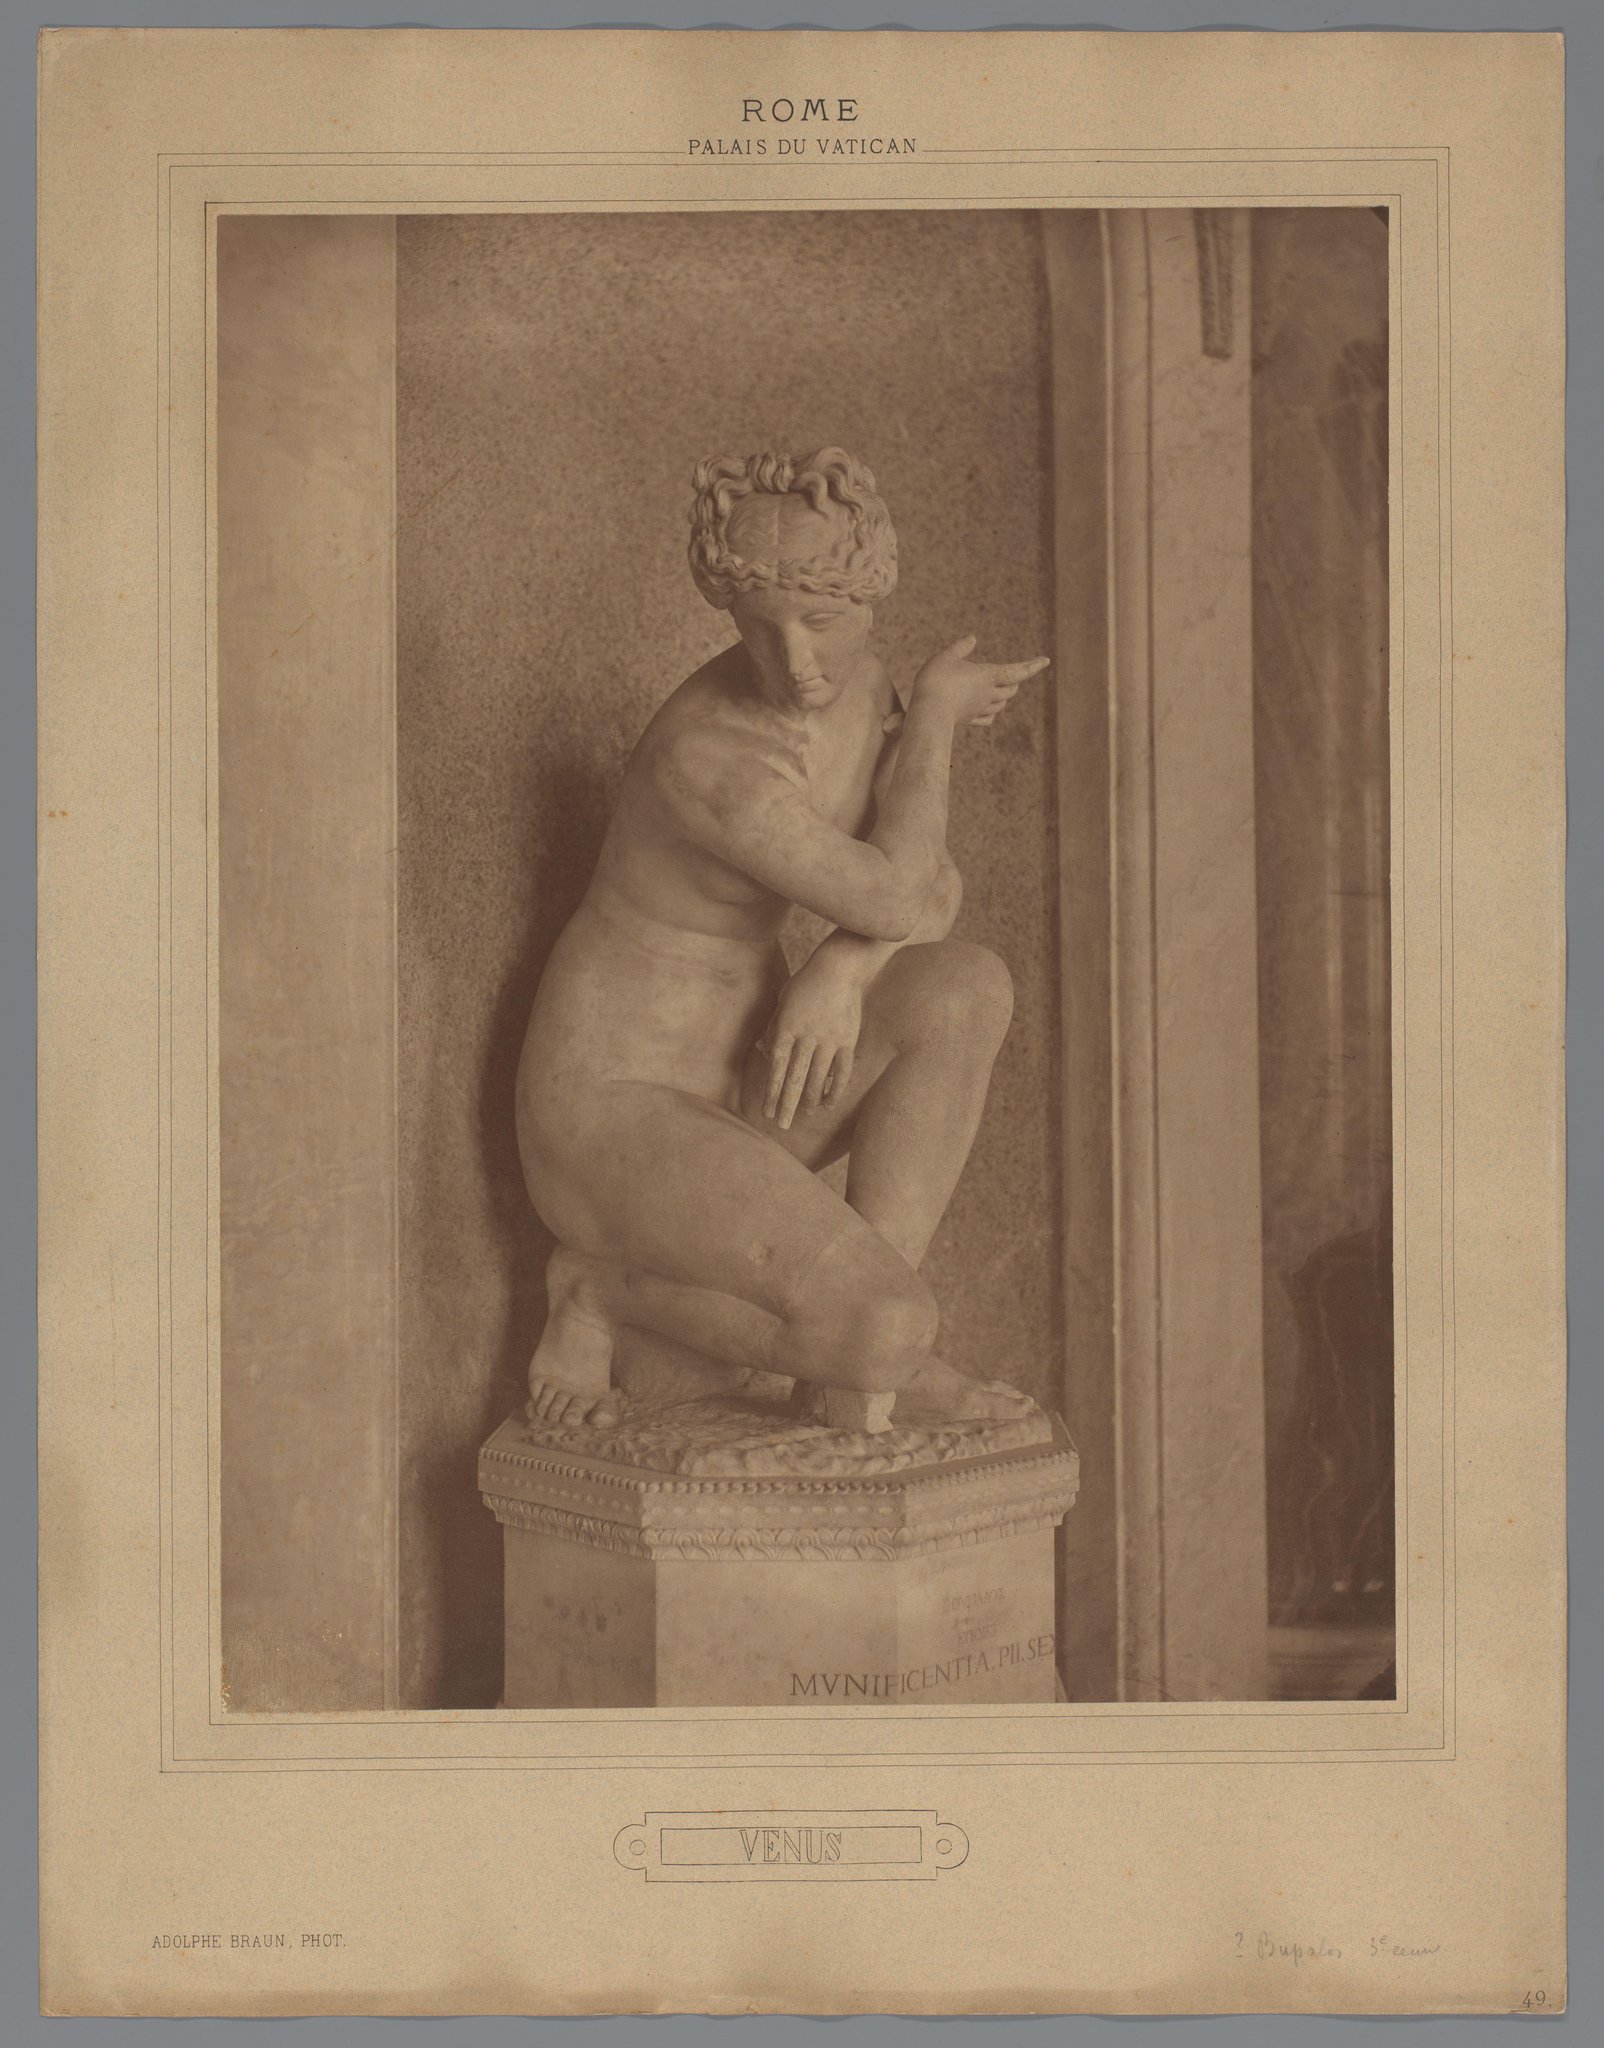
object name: photograph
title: Sculptuur van Venus (coll. Vaticaanse Musea)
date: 1880-1900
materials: cardboard, paper, photographic support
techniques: carbon print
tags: vaticaanse musea